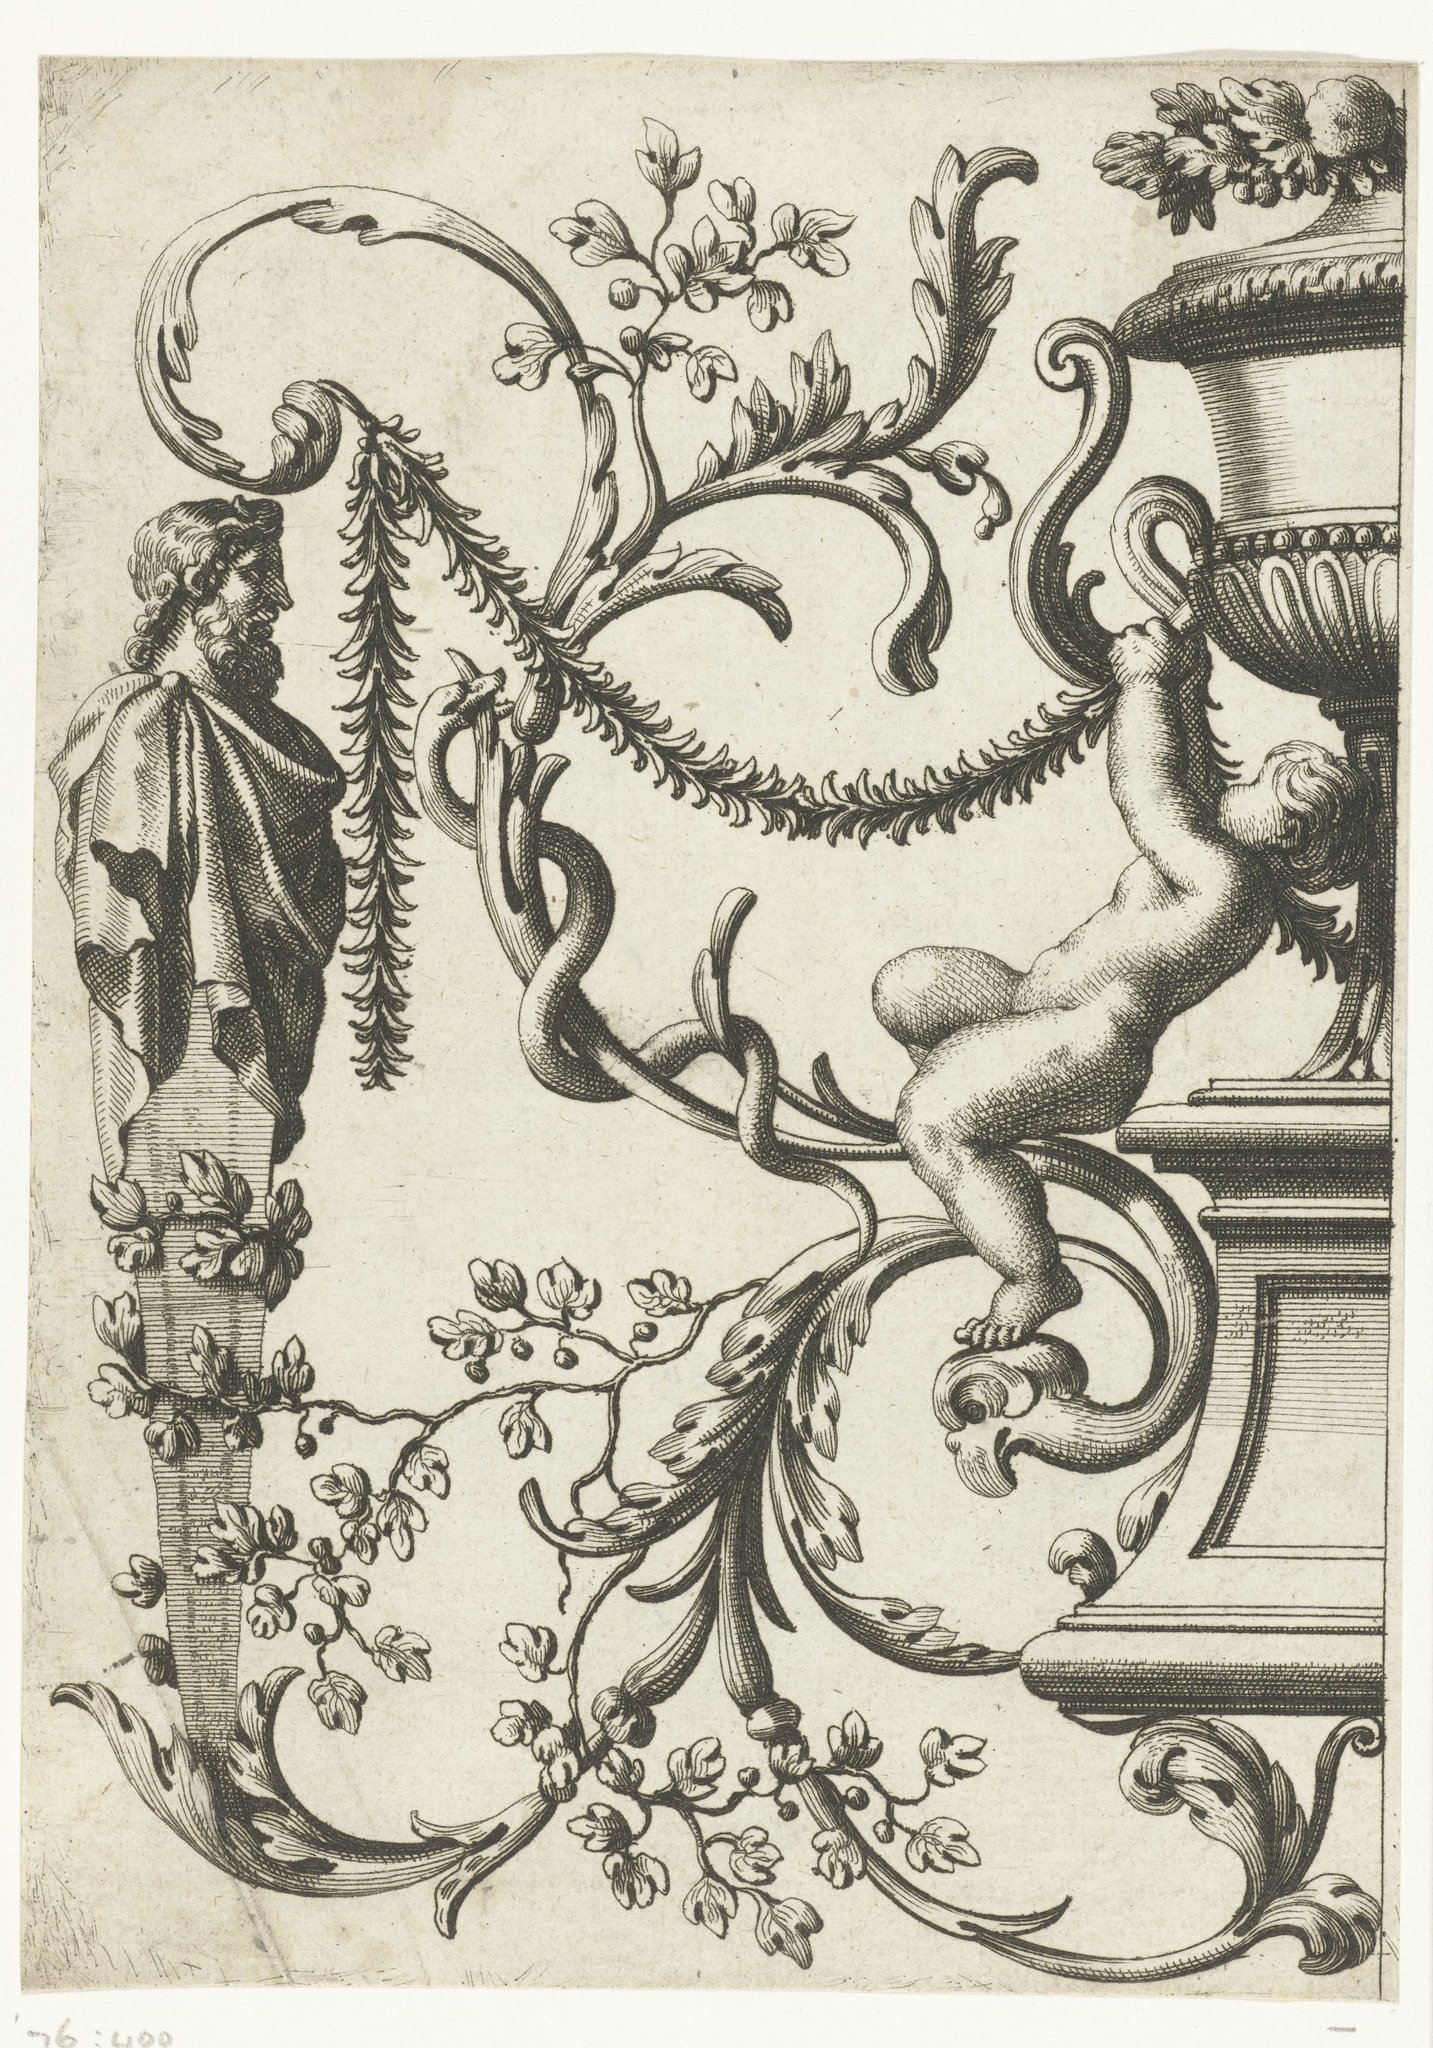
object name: ornament print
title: Linkerhelft van paneel met herme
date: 1628-1682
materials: paper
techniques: etching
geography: paris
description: Rechts staat een vaas op een voetstuk, ernaast houdt een putto een guirlande van bladeren vast.